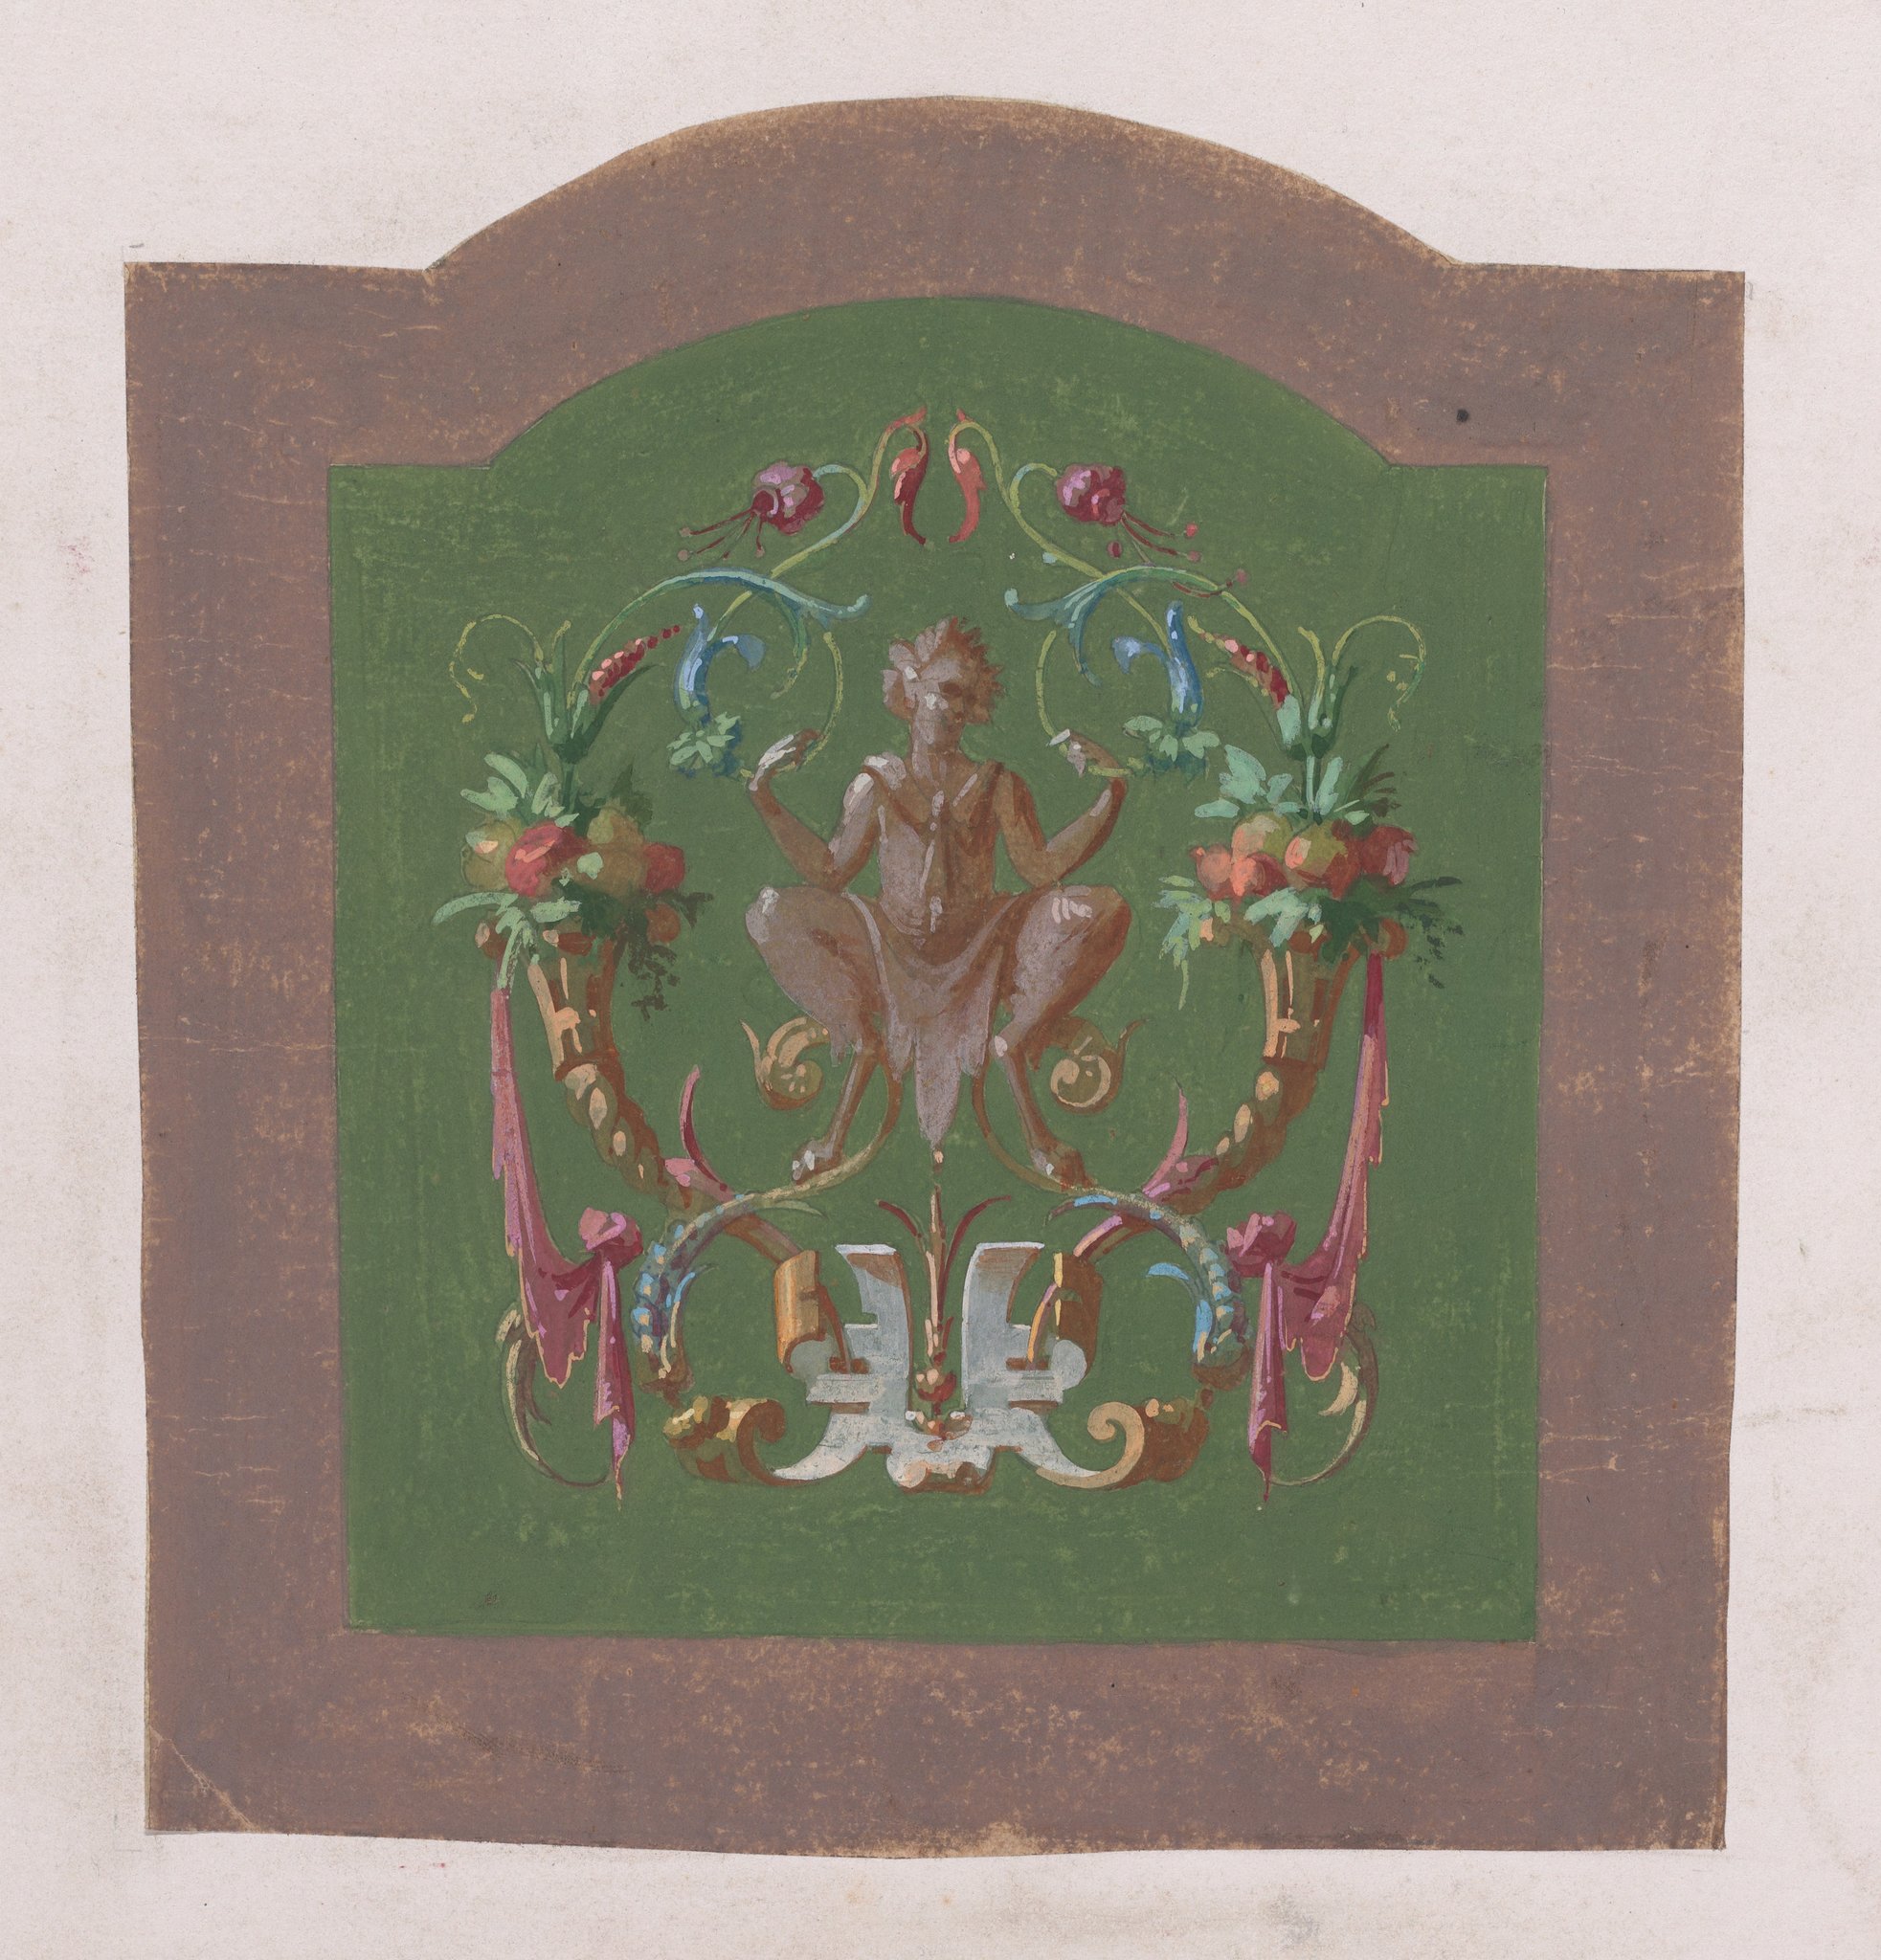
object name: drawing ornament architecture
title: Design for a Chair Back Cover with a Squatting Half-Human Grotesque Figure Inside an Ornamental Frame Made of Two Cornucopias Holding Bundles of Leaves and Fruits and Scrolls of Leaves and Flowers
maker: anonymous, french, 19th century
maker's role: designer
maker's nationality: french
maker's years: 1800-1900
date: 1870-1900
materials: gouache, watercolor